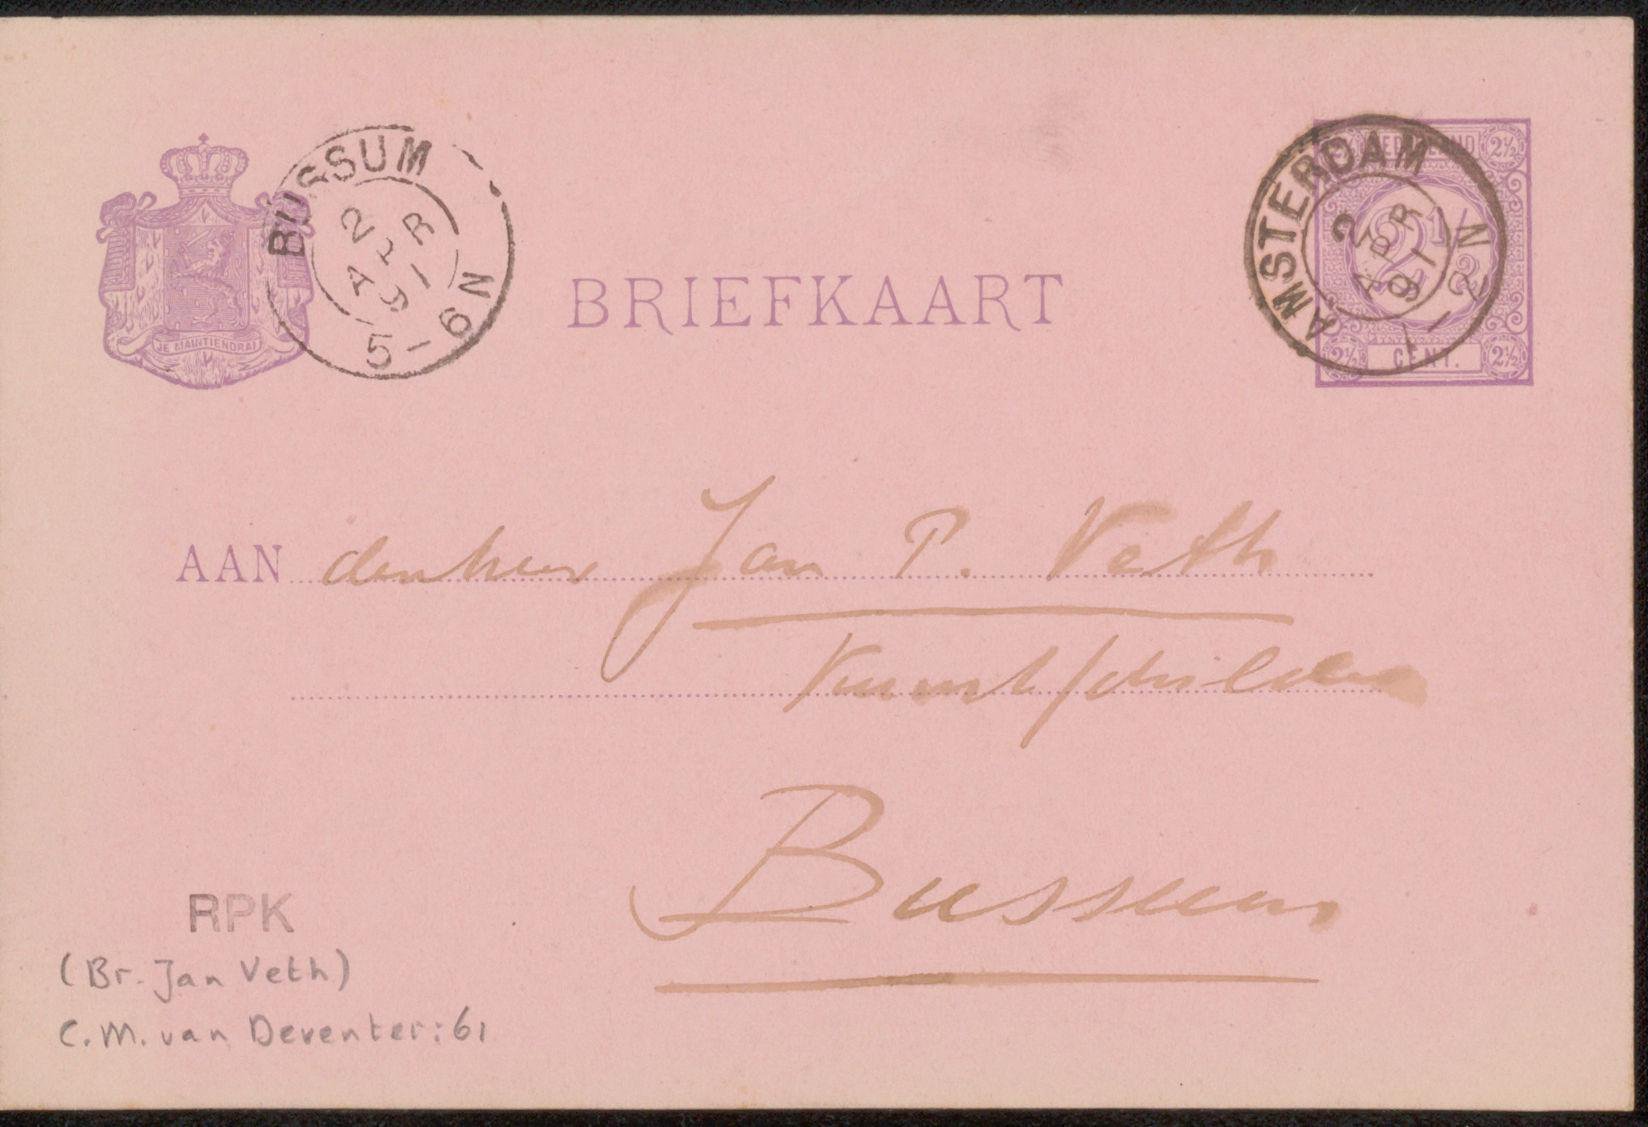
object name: postcard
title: Briefkaart aan Jan Veth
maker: chap van deventer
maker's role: kunstcriticus, scheikundige, schrijver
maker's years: 1860-1931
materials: cardboard, ink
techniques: pen, writing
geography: amsterdam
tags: painter, print maker, draughtsman, designer, jan veth, literature ~ arts, anonymous historical person portrayed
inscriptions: collector's mark: ‘RPK’